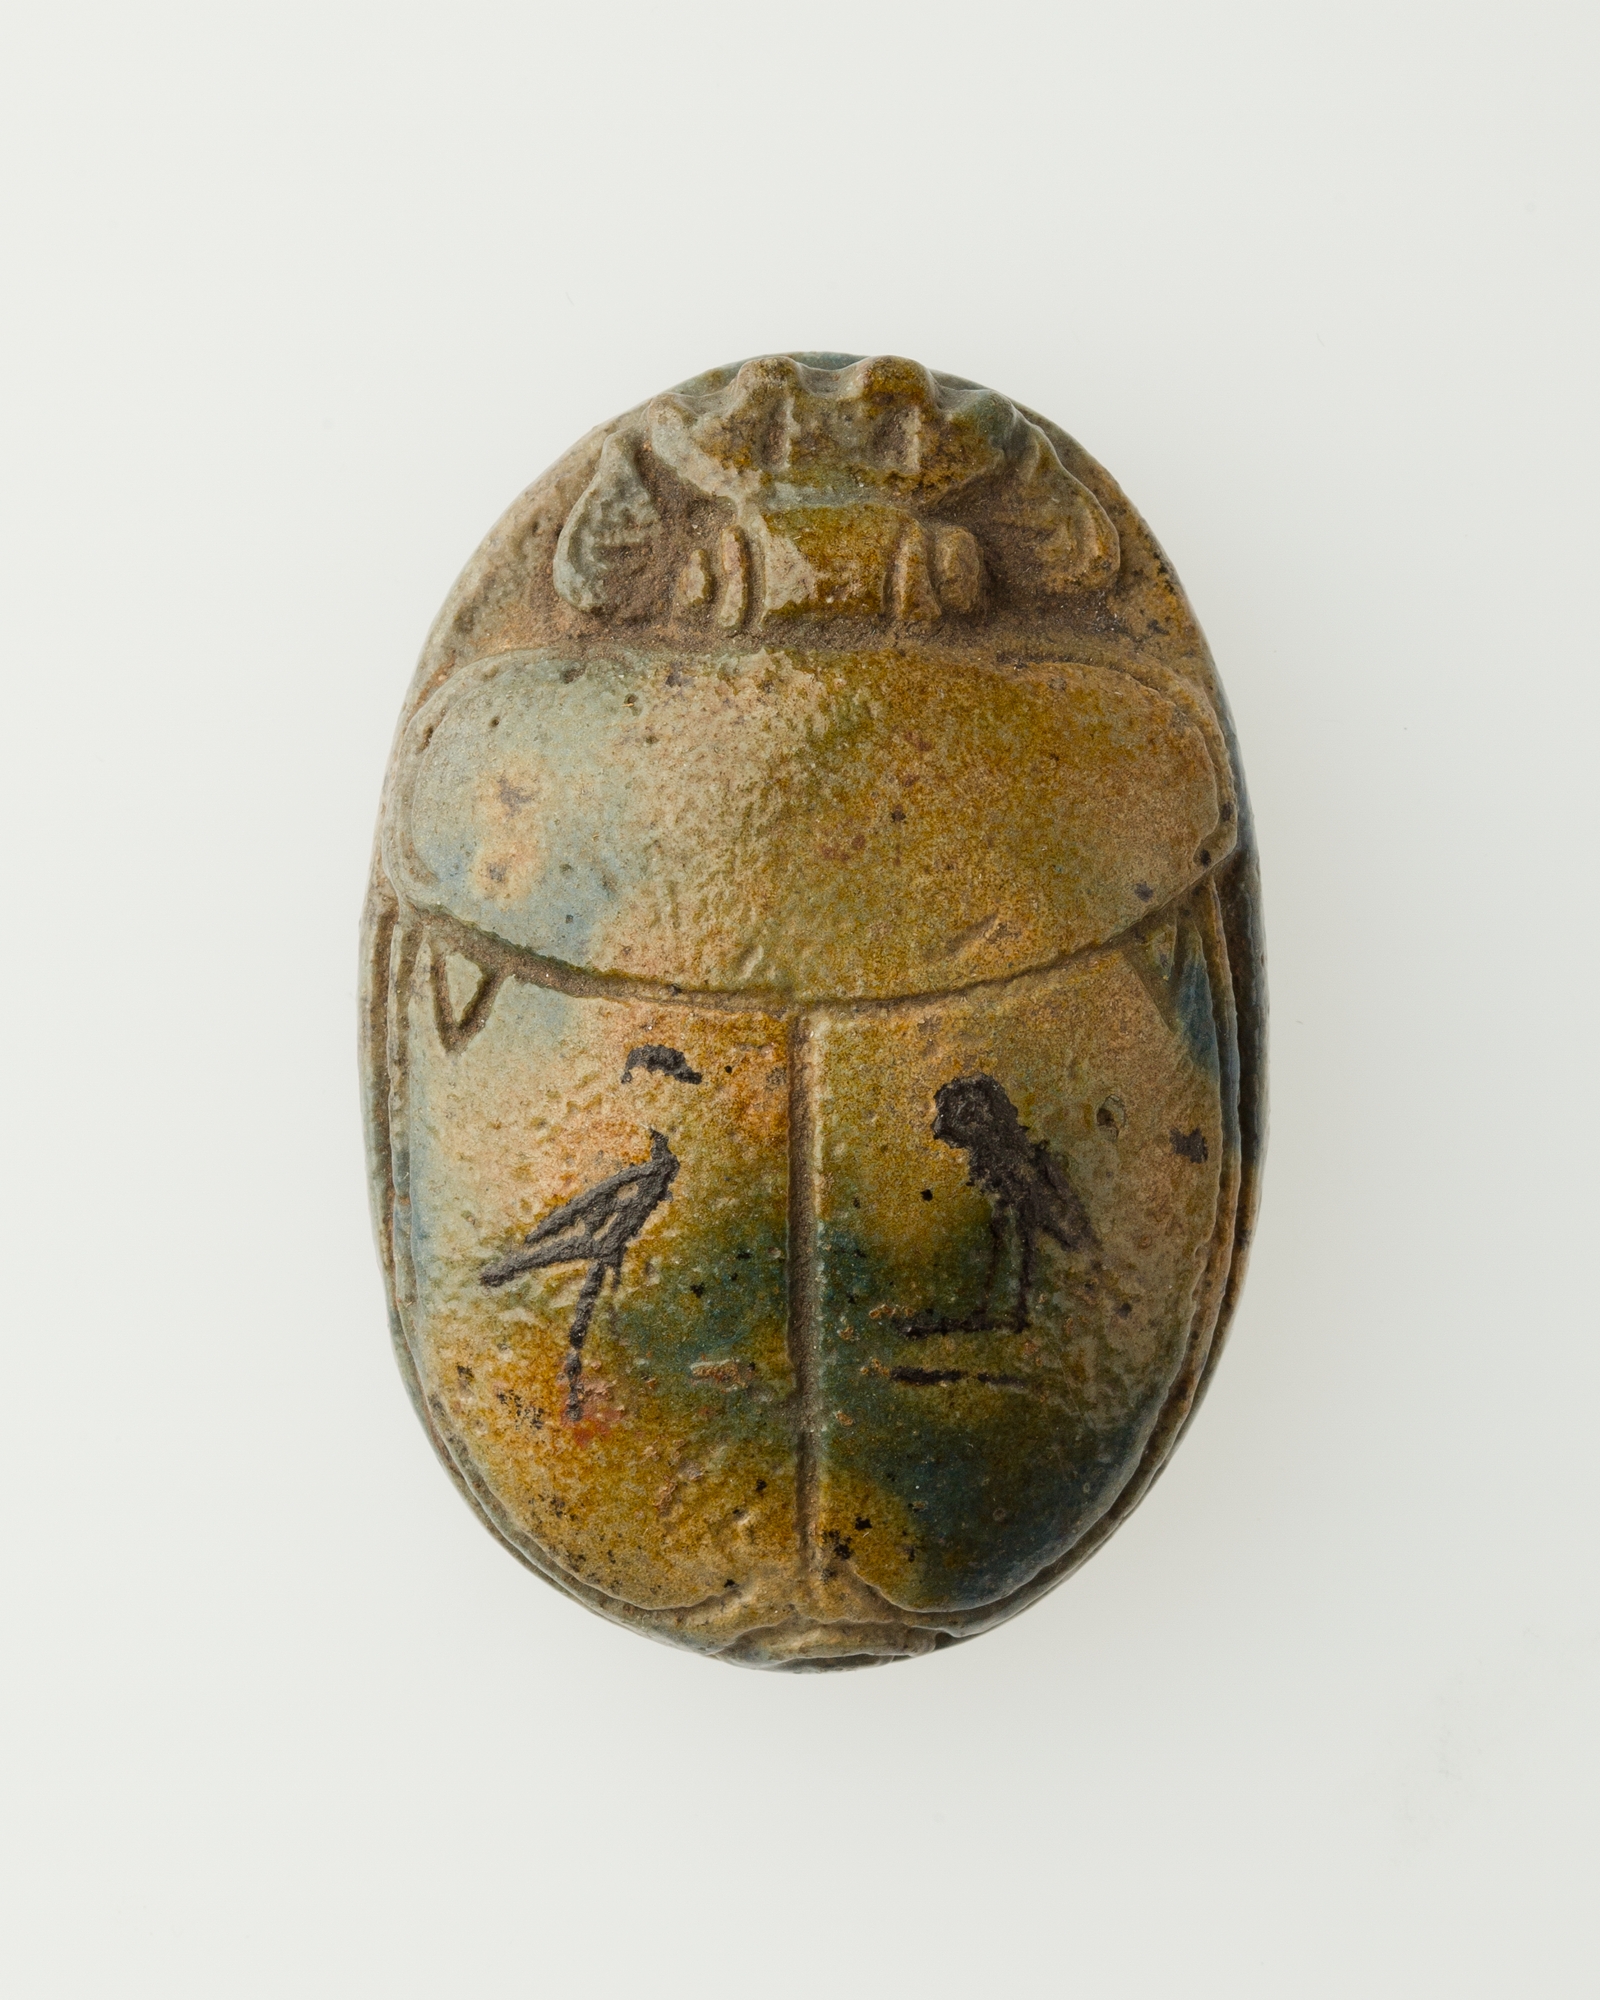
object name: heart scarab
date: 1550-1070 BCE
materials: faience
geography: egypt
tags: hieroglyphs,scarabs